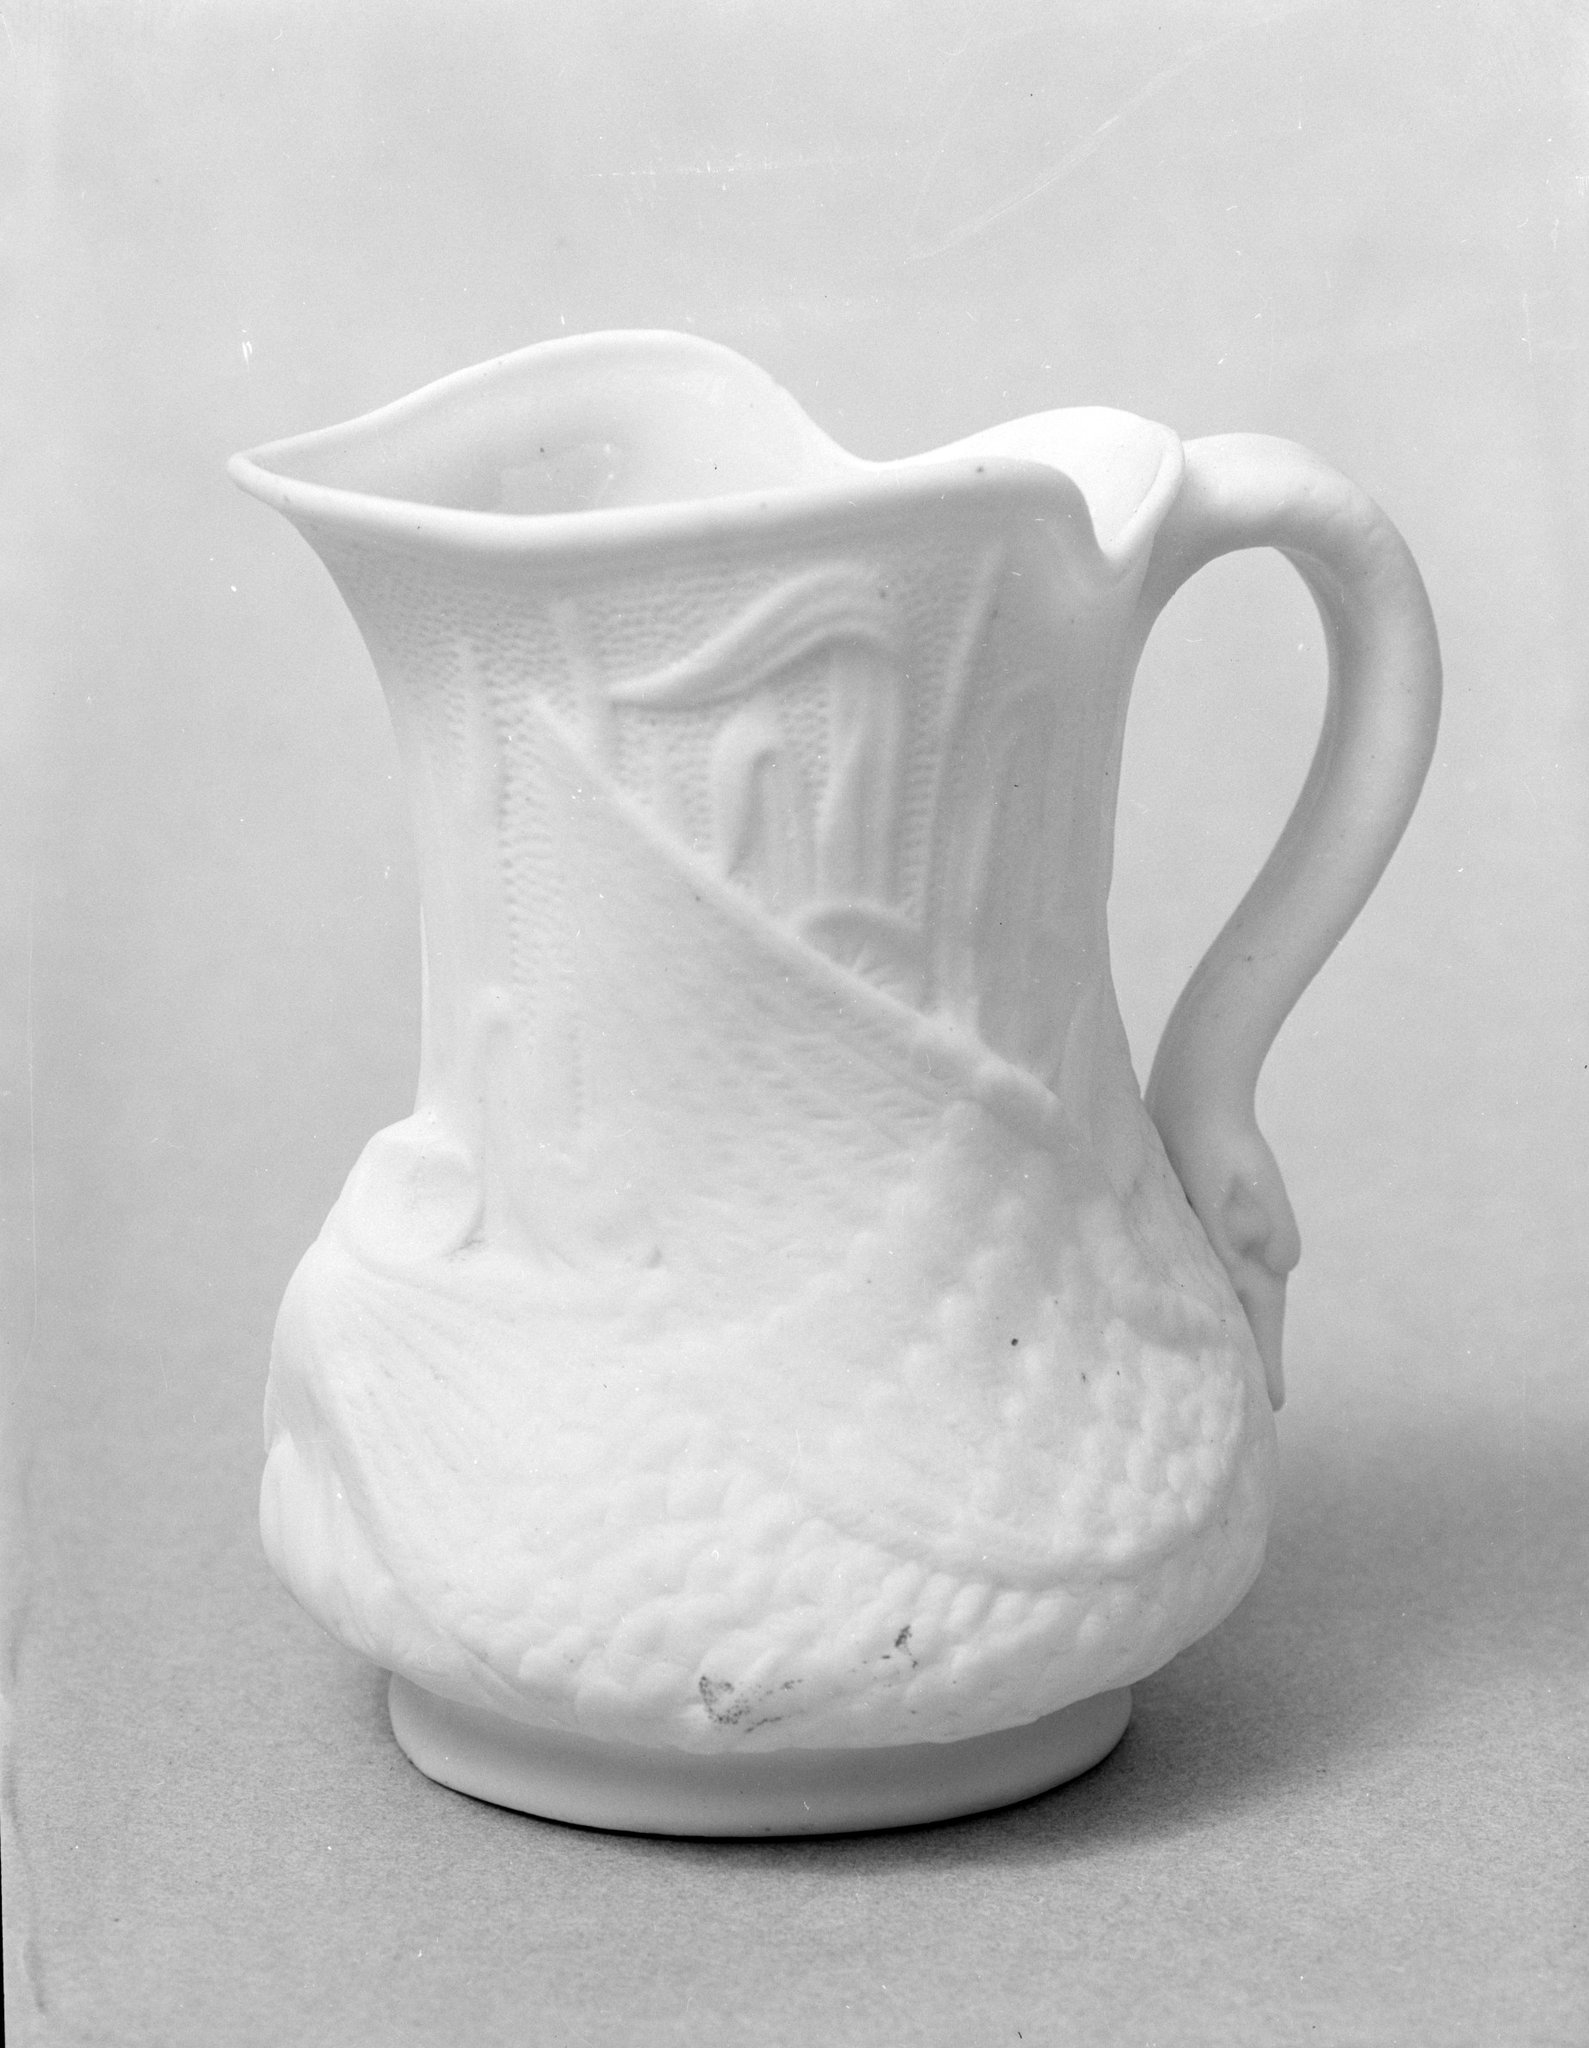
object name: pitcher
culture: american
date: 1830-1870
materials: porcelain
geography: united states